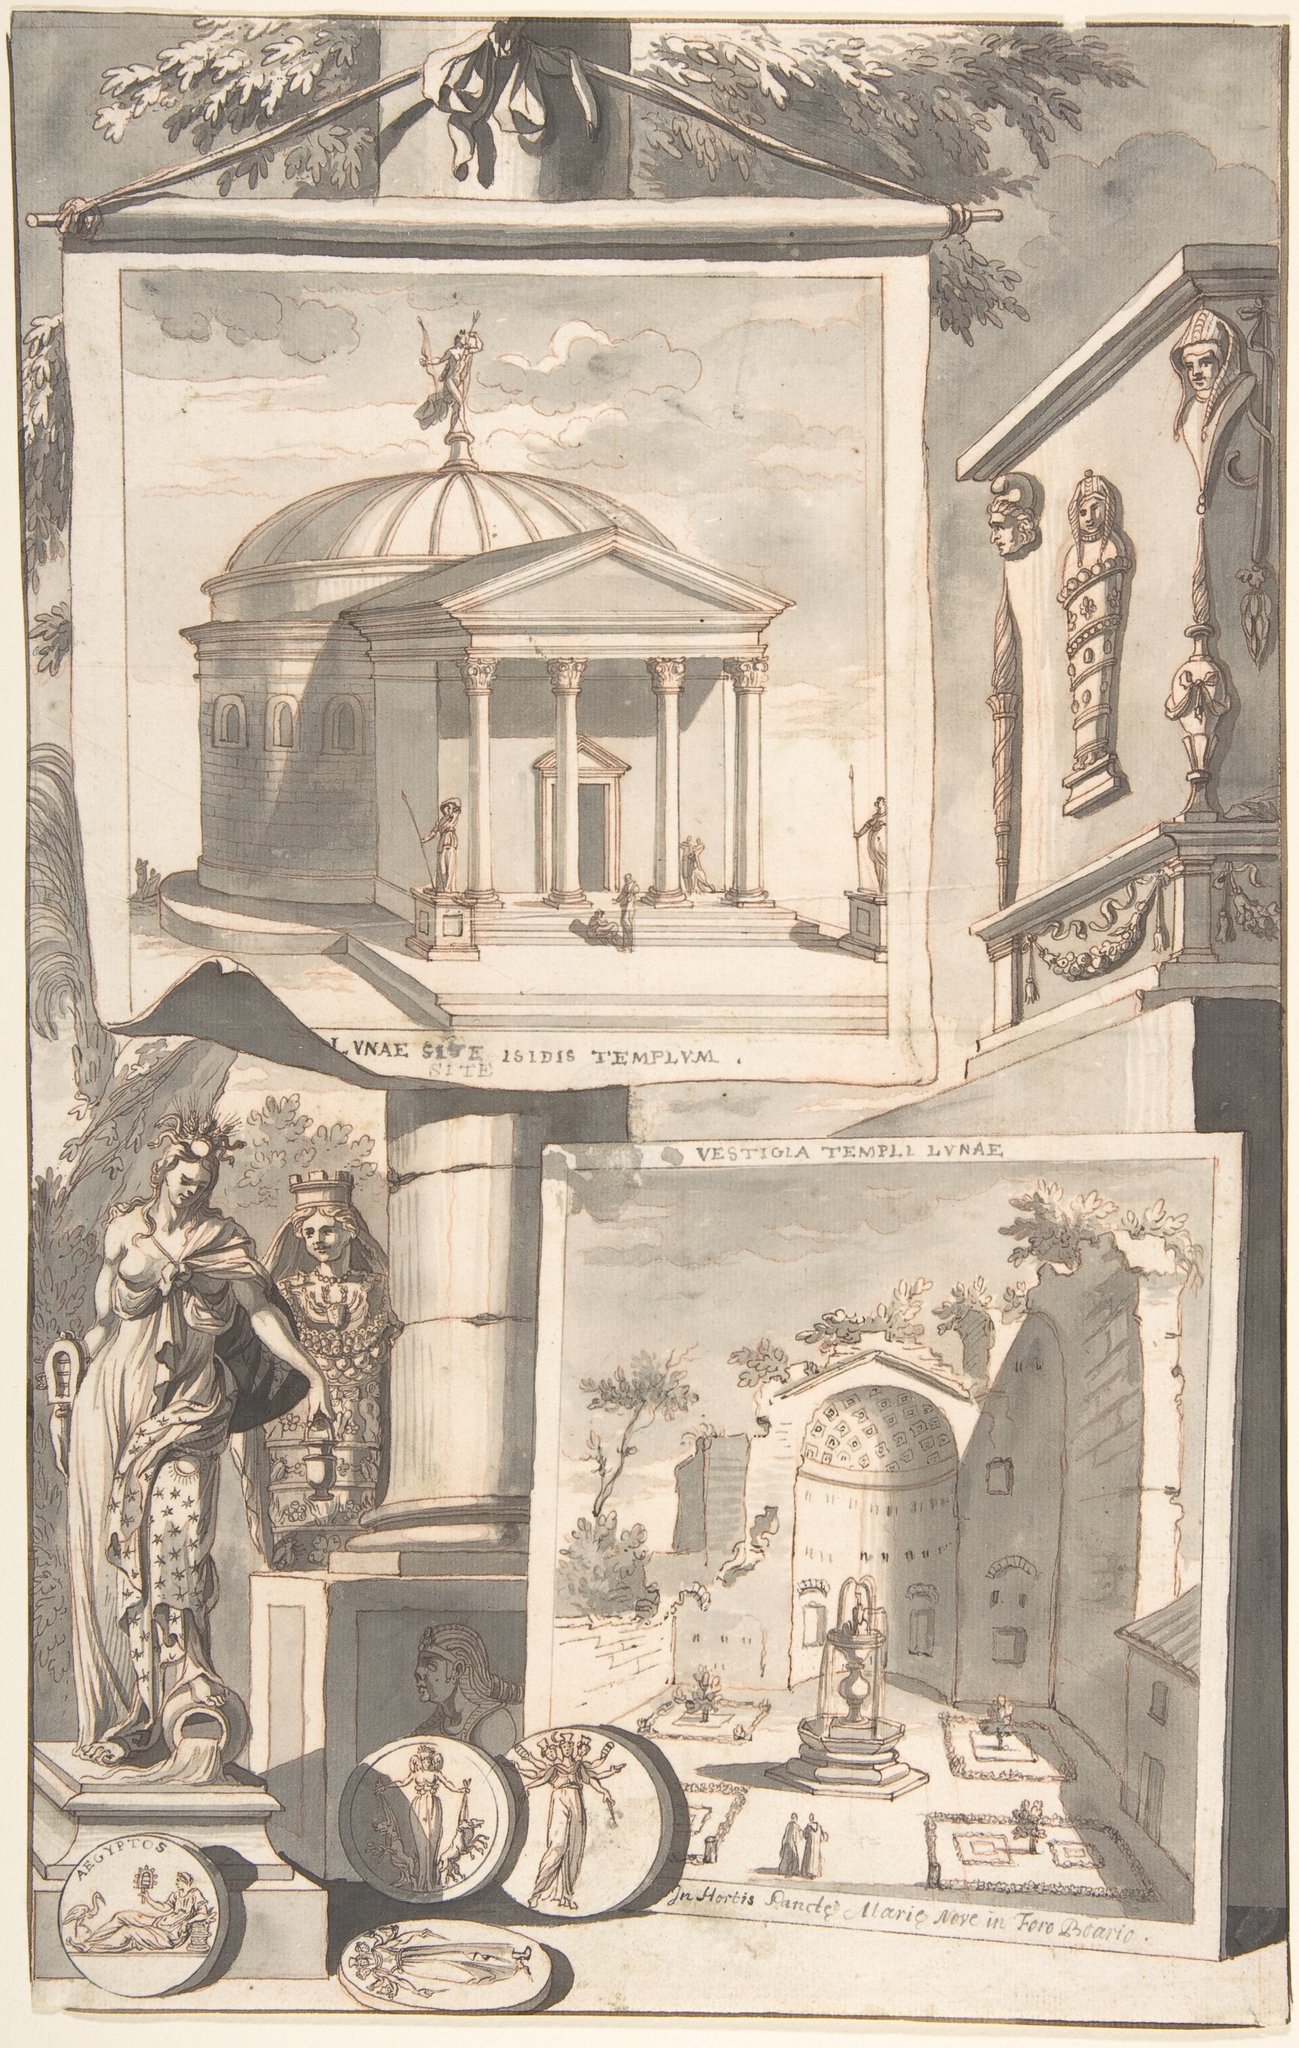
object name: drawing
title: A Reconstruction of the Templum Isis (above) and a View of the Ruins (below)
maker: jan goeree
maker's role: artist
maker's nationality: dutch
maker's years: 1670-1731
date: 1704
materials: chalk, ink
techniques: brush, pen, wash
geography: italy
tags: buildings,ruins